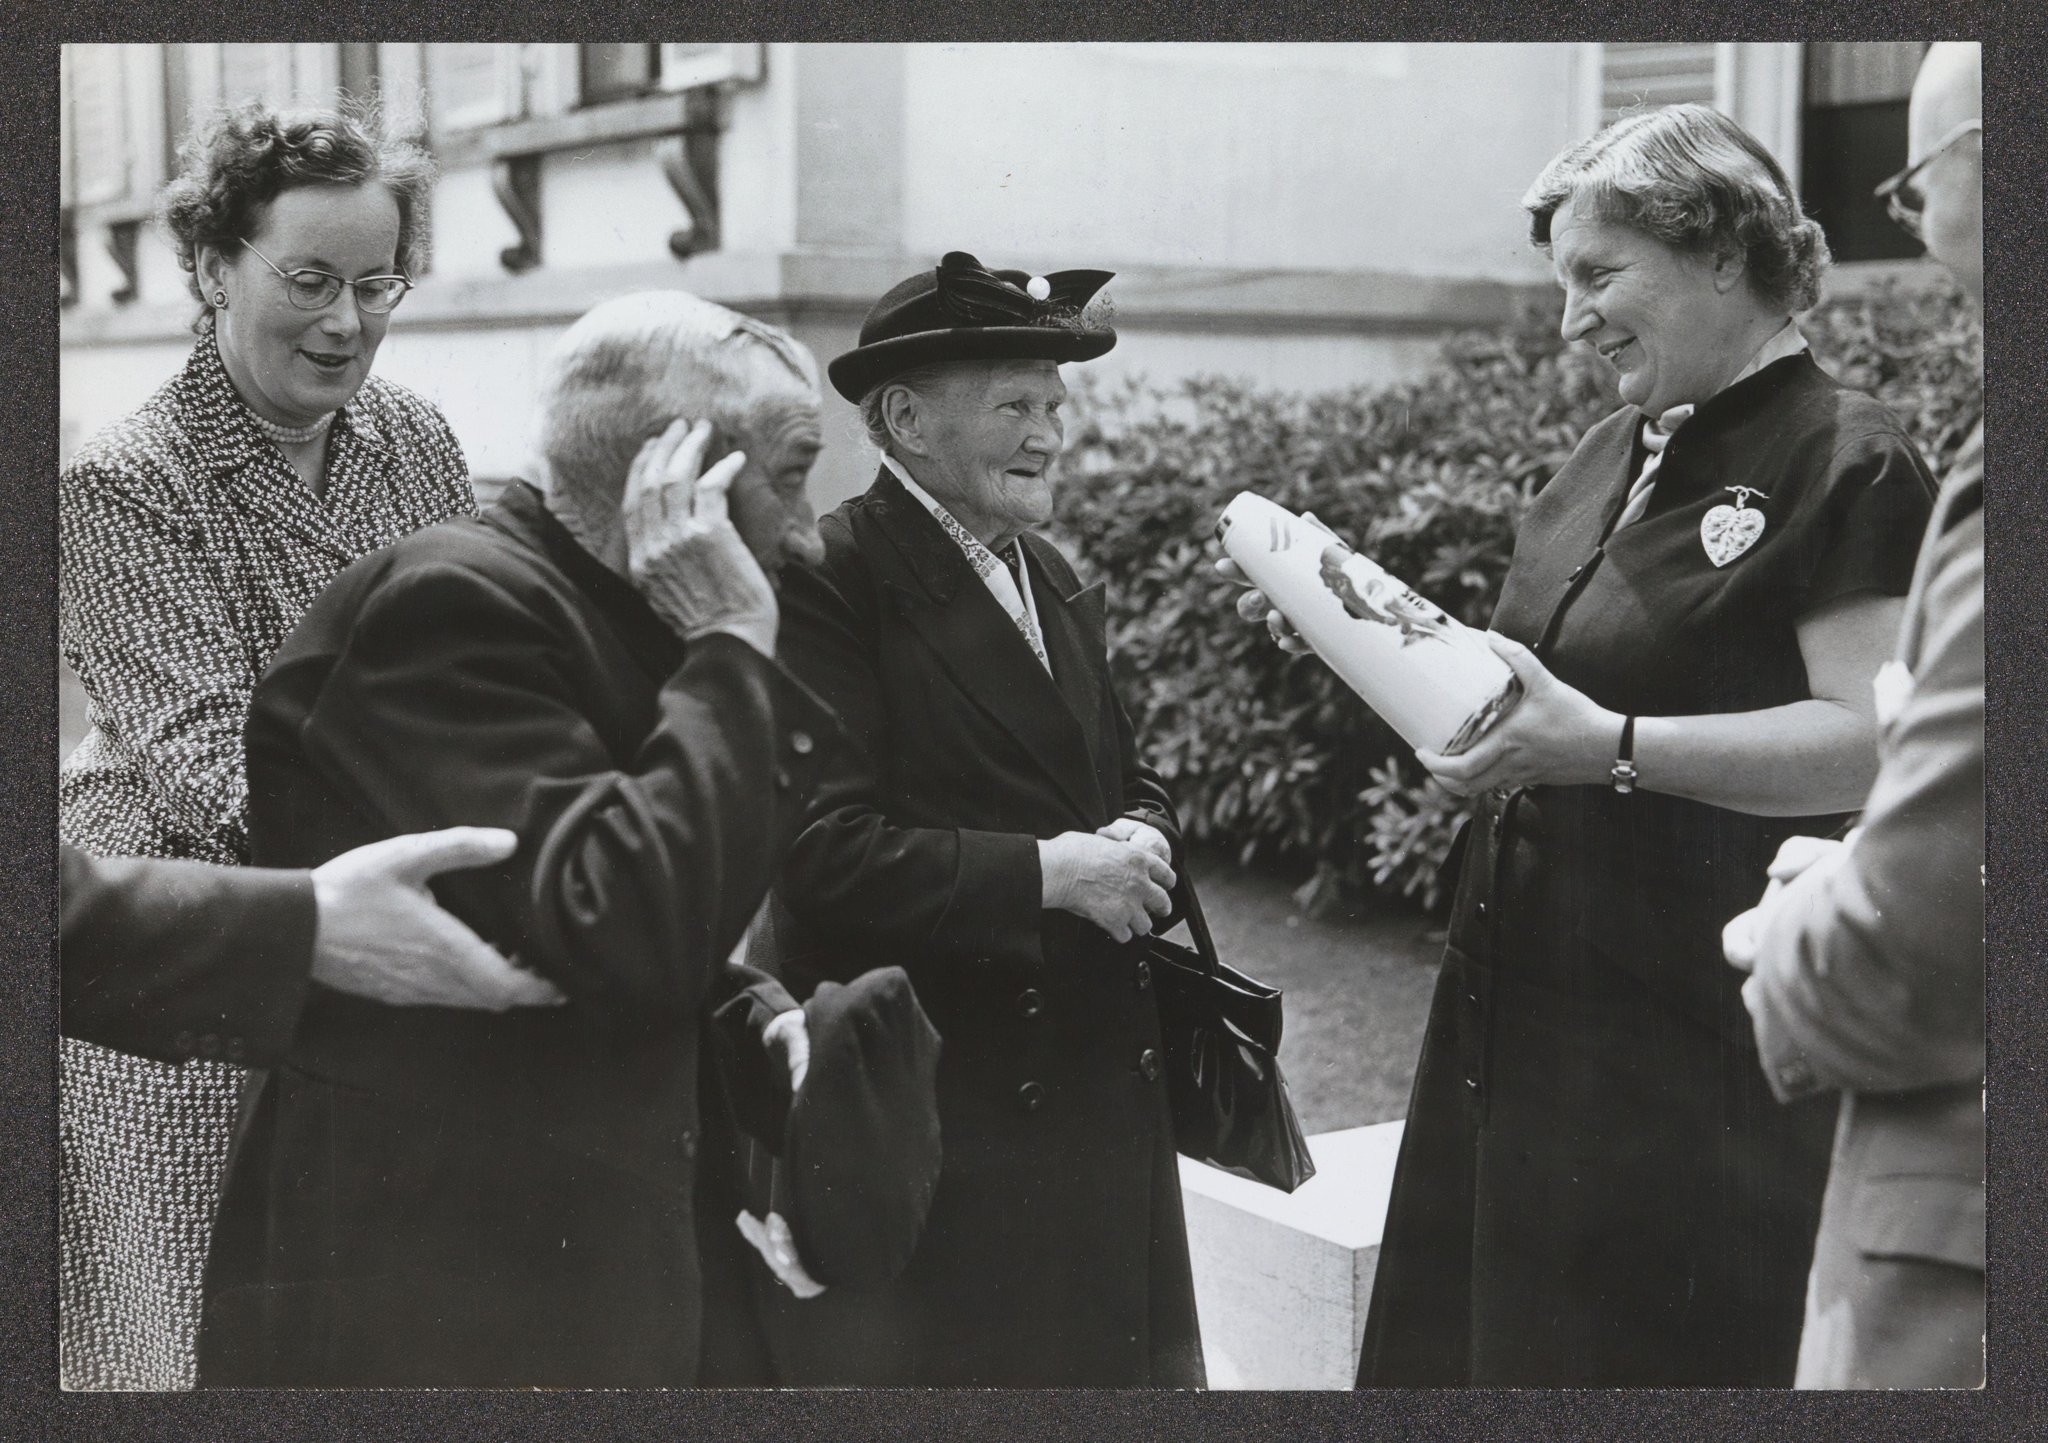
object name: photograph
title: Een oude dame en heer bieden Koningin Juliana een vaas aan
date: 1955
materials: paper, photographic support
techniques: gelatin silver print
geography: amsterdam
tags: juliana of the netherlands, the hague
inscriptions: annotation: ‘Woensdagmiddag hebben de ouden van dagen uit de Brabantse dorpen Nuland, Boekel en Berlicum gedefileerd voor H.M de Koningin op ht Paleis Soestdijk’